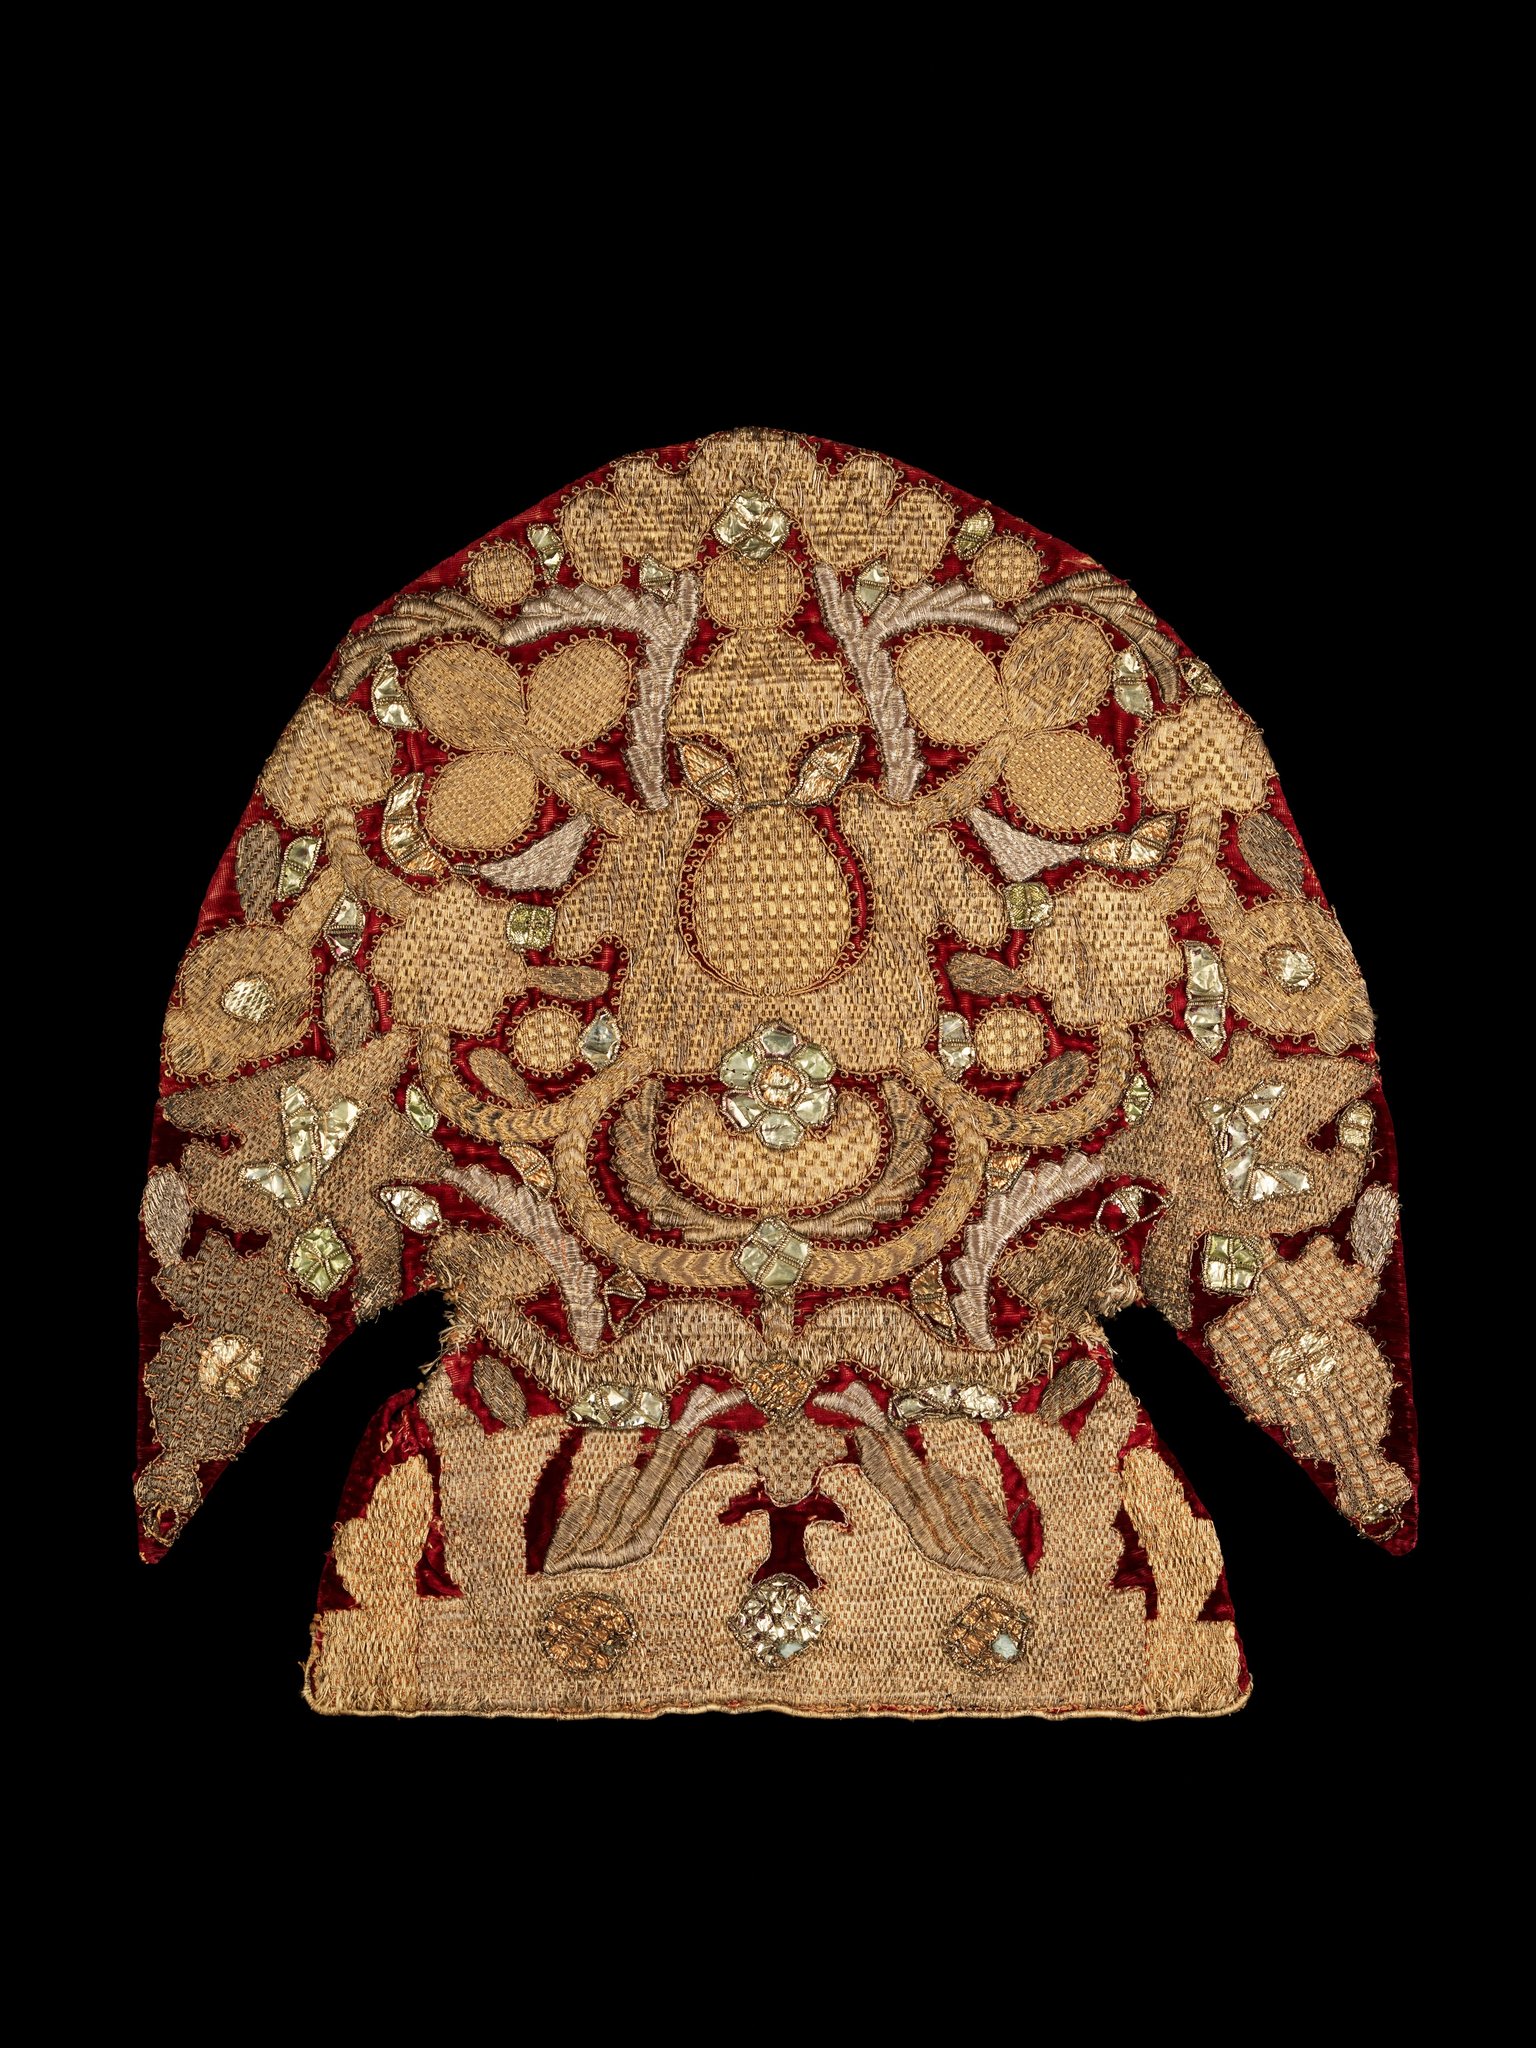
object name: headdress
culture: russian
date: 1801-1900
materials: linen, metal, silk